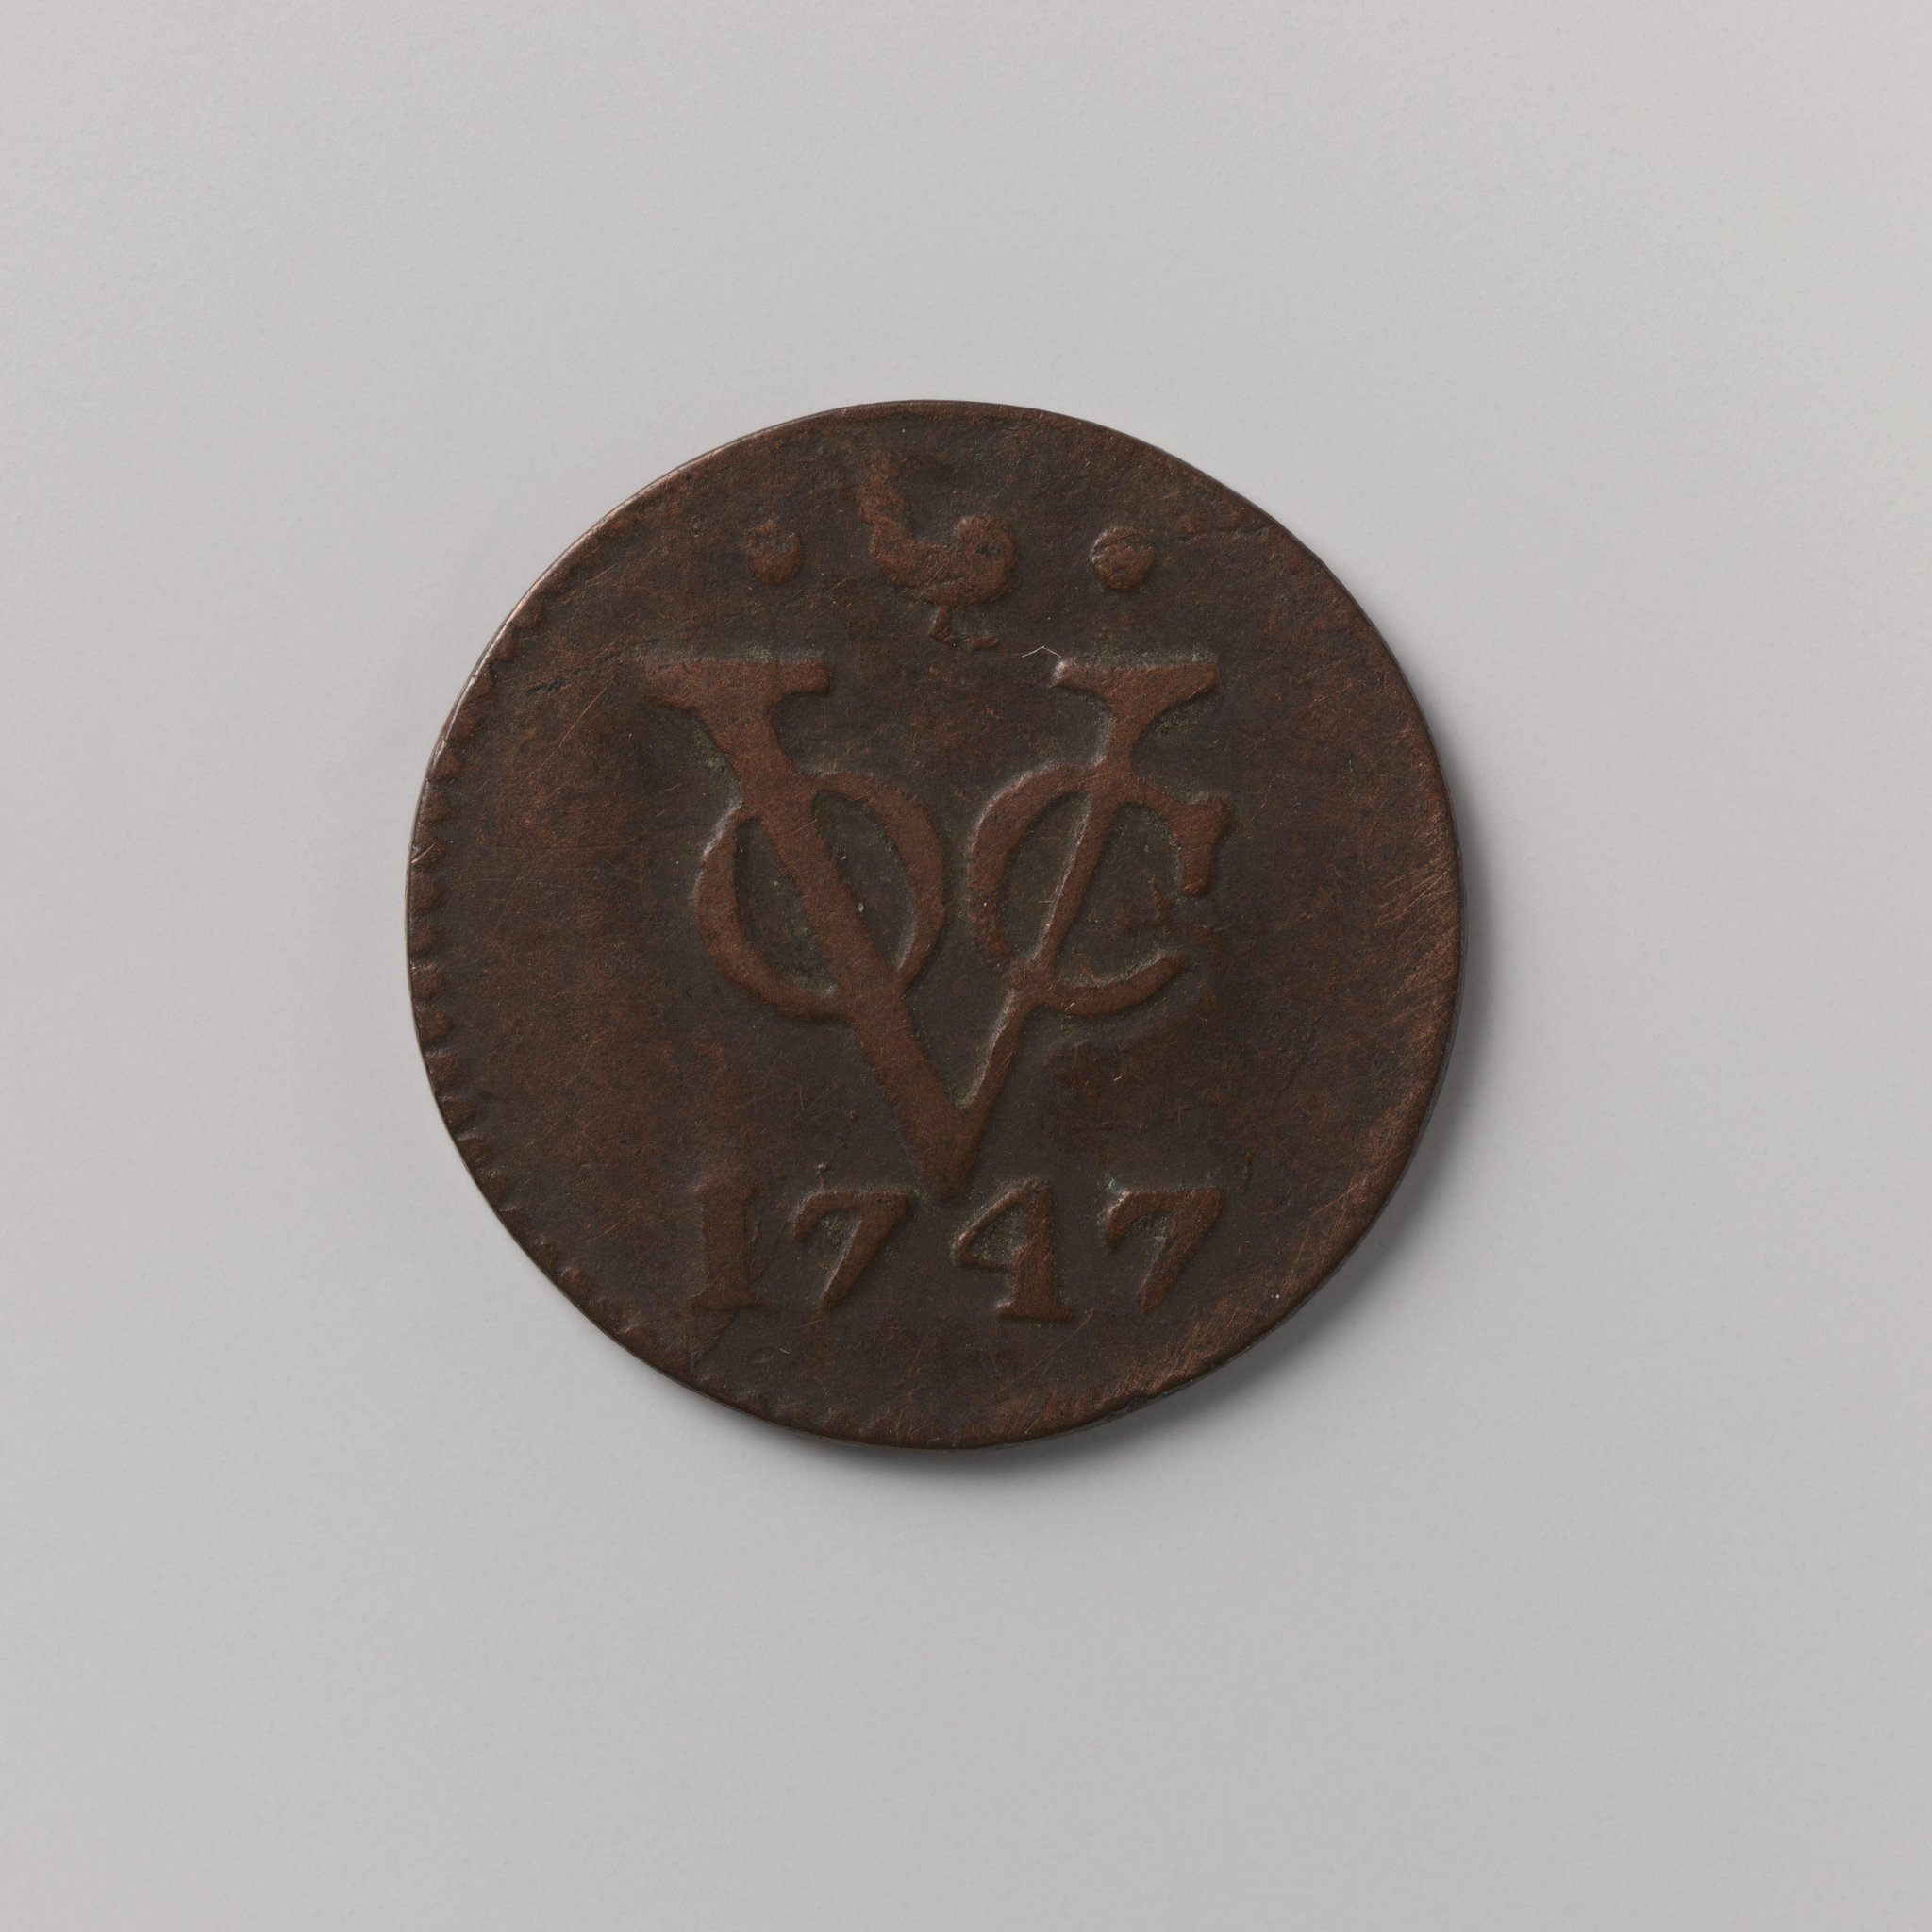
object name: coin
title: Duit van de VOC uit Westfriesland, 1747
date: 1747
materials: copper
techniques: striking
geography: medemblik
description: Koperen munt. Voorzijde: gekroond wapenschild van Westfriesland. Keerzijde: monogram van de VOC, waarboven muntmeesterteken en waaronder jaartal. Gladde rand.